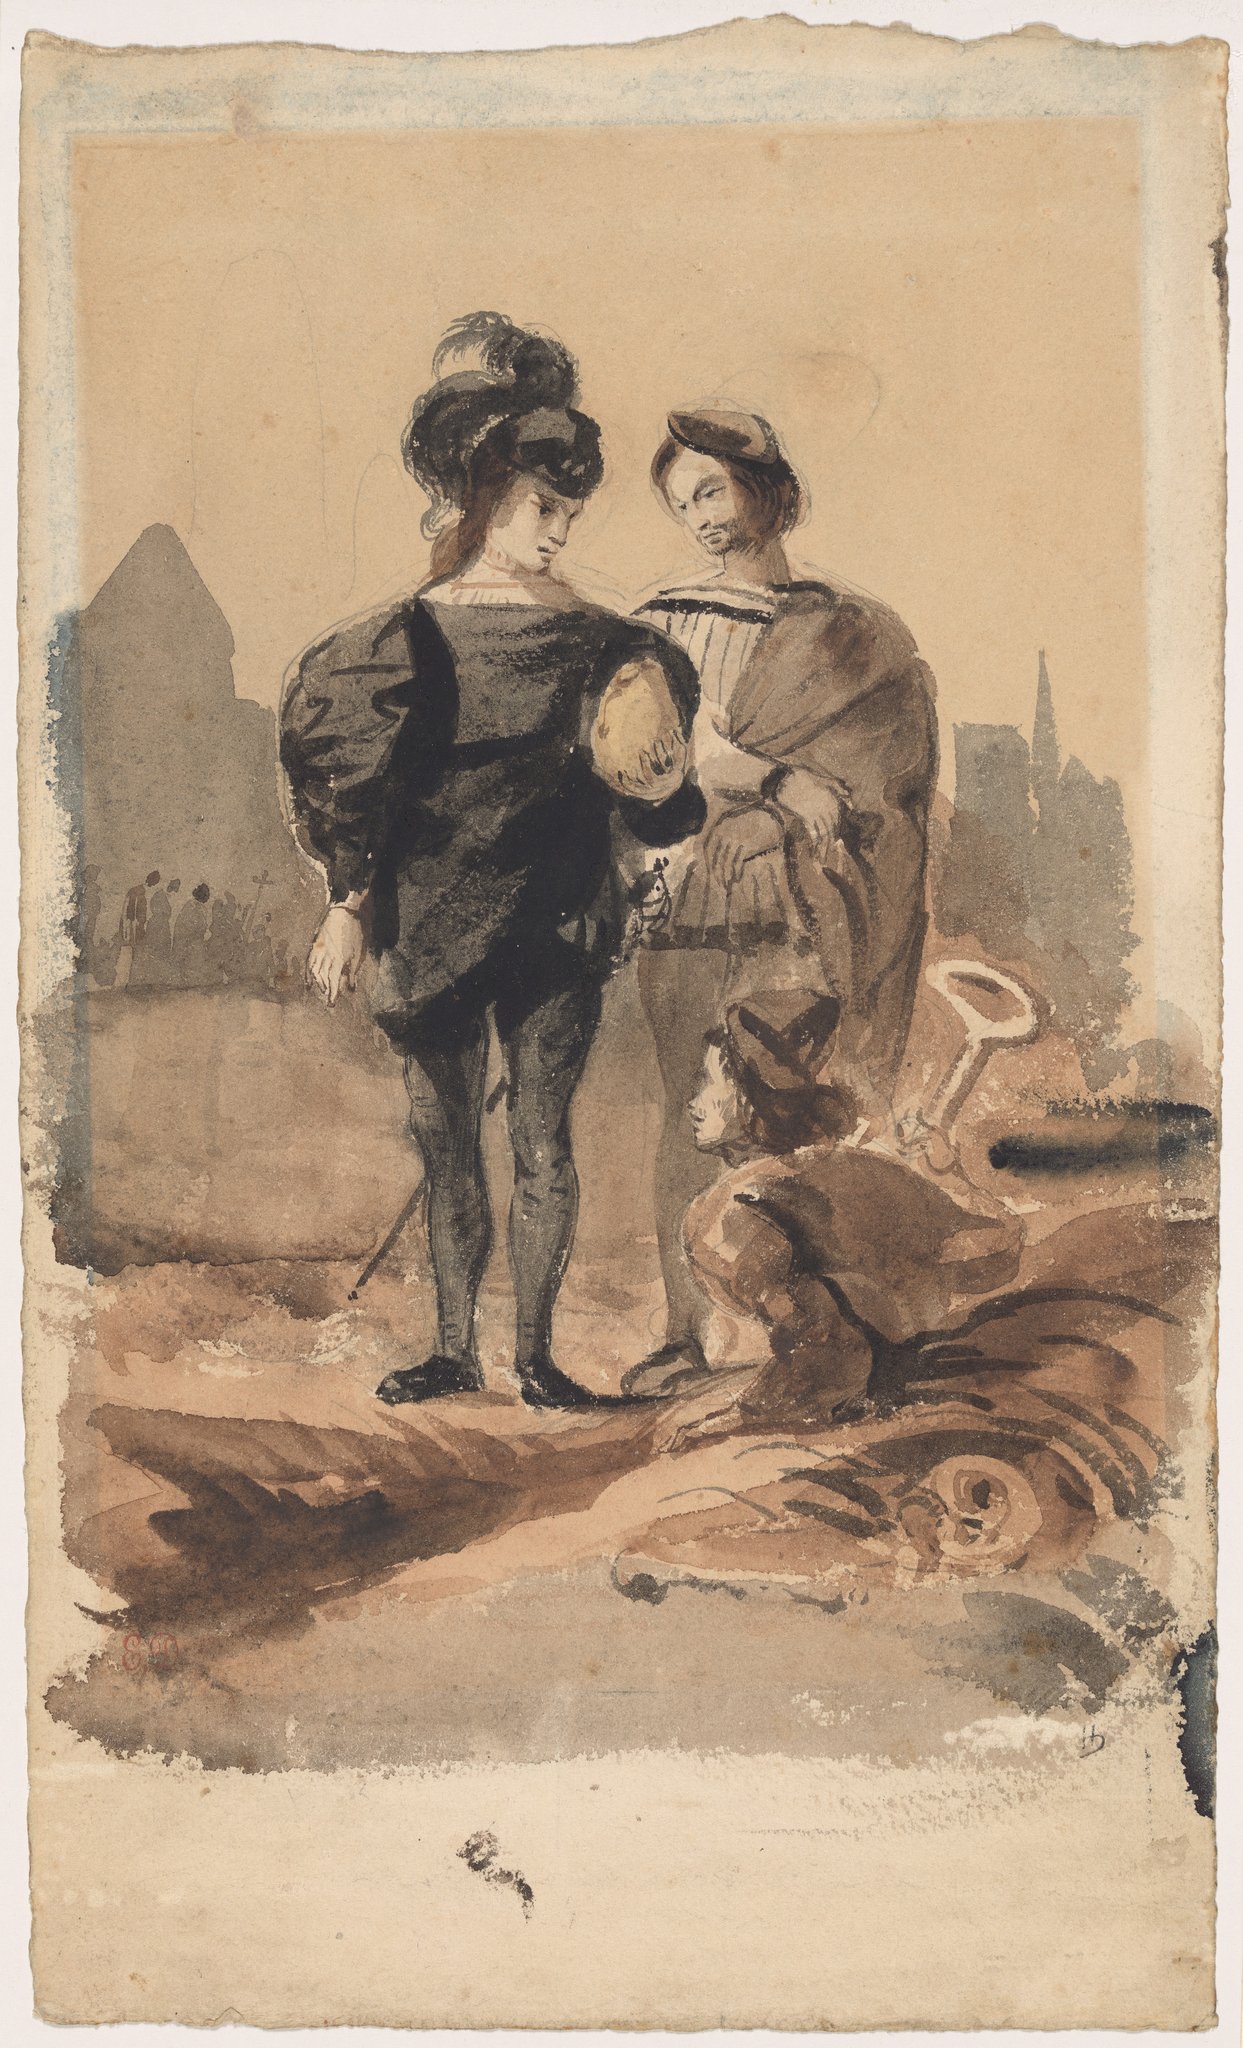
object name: drawing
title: Hamlet and Horatio in the Graveyard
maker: eugène delacroix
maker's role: artist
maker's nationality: french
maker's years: 1798-1863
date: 1827-1828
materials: graphite, paper, watercolor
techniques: brush, wash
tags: shakespeare,men,hamlet